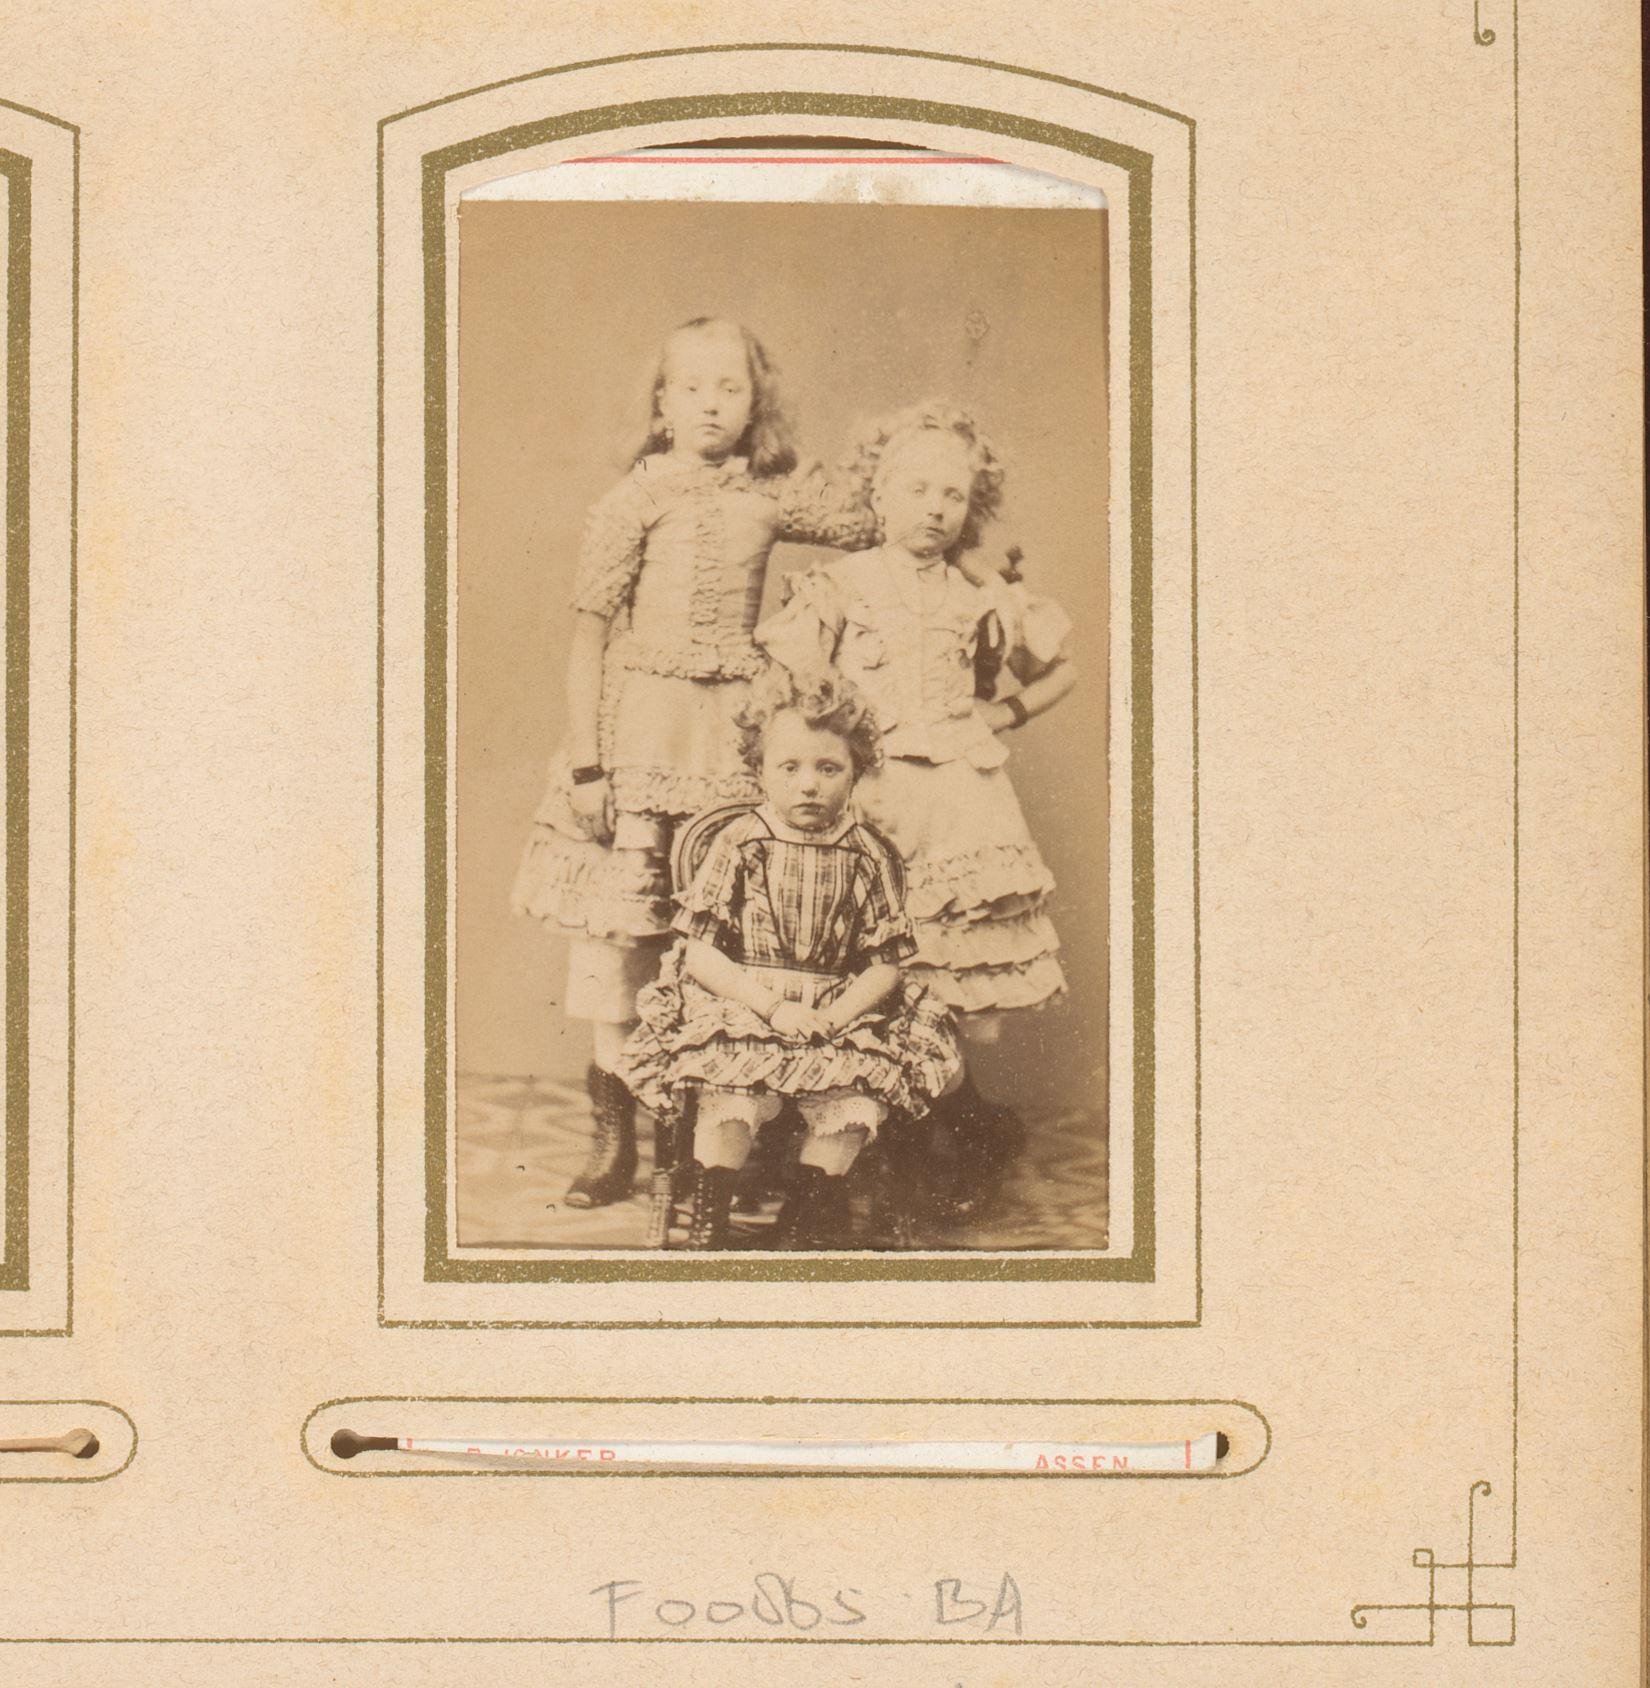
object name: carte de visite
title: Portret van drie meisjes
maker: bartel jonker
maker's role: fotograaf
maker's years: 1842-1913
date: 1877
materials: cardboard, photographic support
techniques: albumen print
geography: assen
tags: girl (child between toddler and youth) (+ three persons), anonymous historical persons portrayed in a group, in a group-portrait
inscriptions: date: ‘1877’, inscription: ‘B. JONKER/ PHOTOGRAPHE/ ASSEN./ Nabestellingen steeds verkrijgbaar./ No. ...’